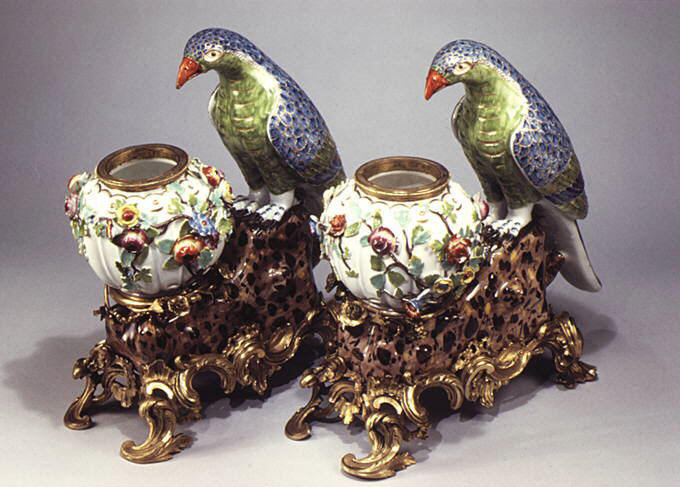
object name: figure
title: Parrot (one of a pair)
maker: meissen manufactory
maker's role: manufactory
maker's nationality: german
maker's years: 1710-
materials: hard paste porcelain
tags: parrots